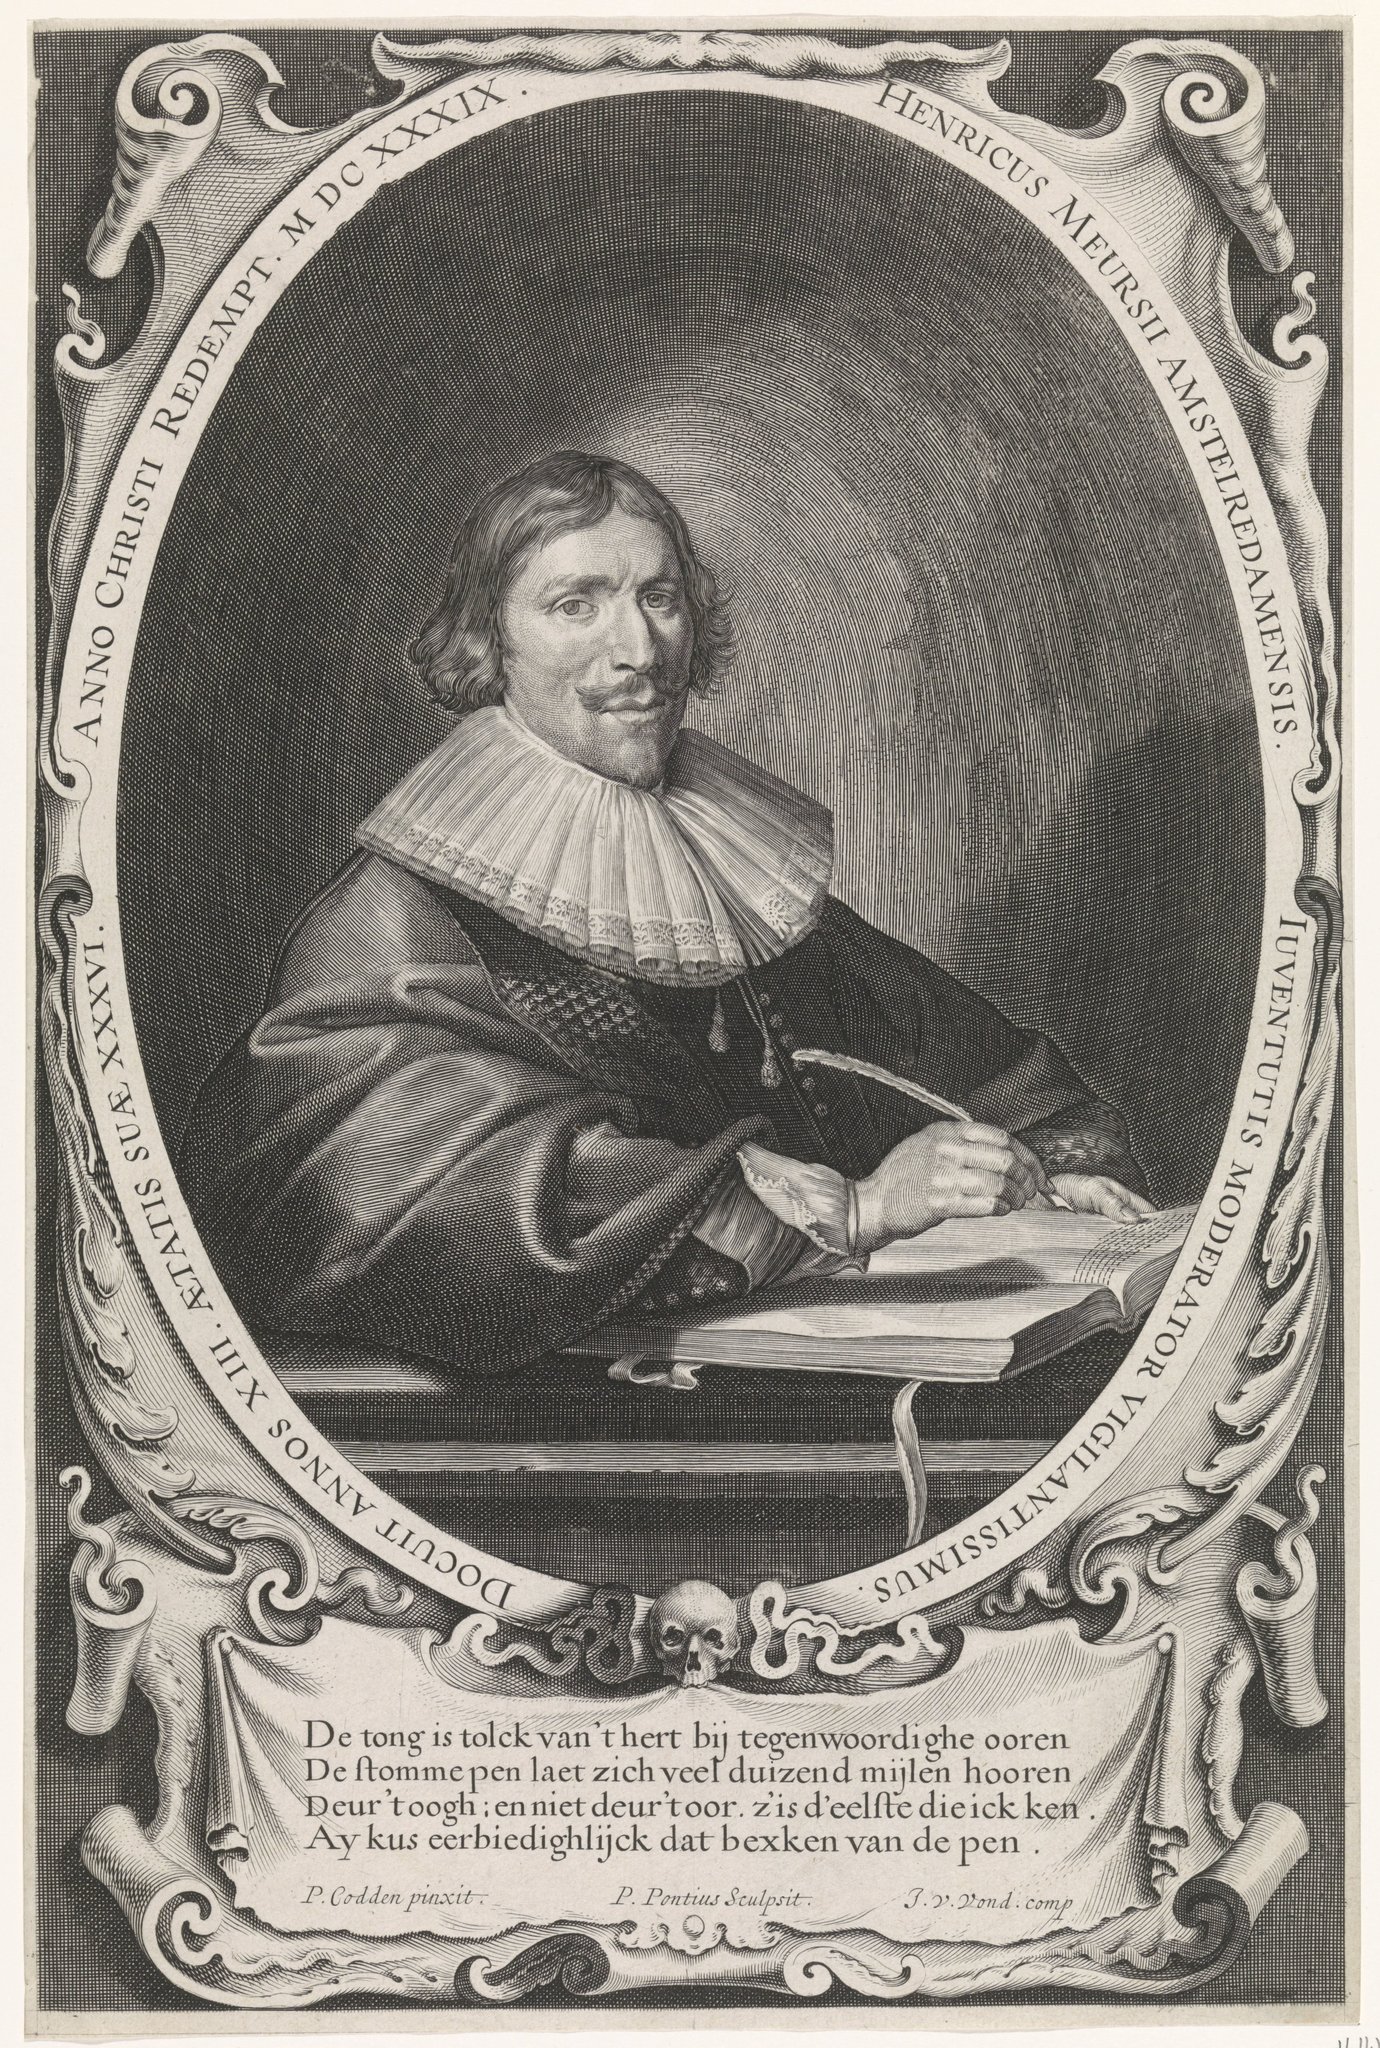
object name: print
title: Portret van Hendrik Meurs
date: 1639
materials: paper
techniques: engraving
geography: antwerp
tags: amsterdam, pen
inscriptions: collector's mark: Lugt 963, collector's mark: Lugt 2228